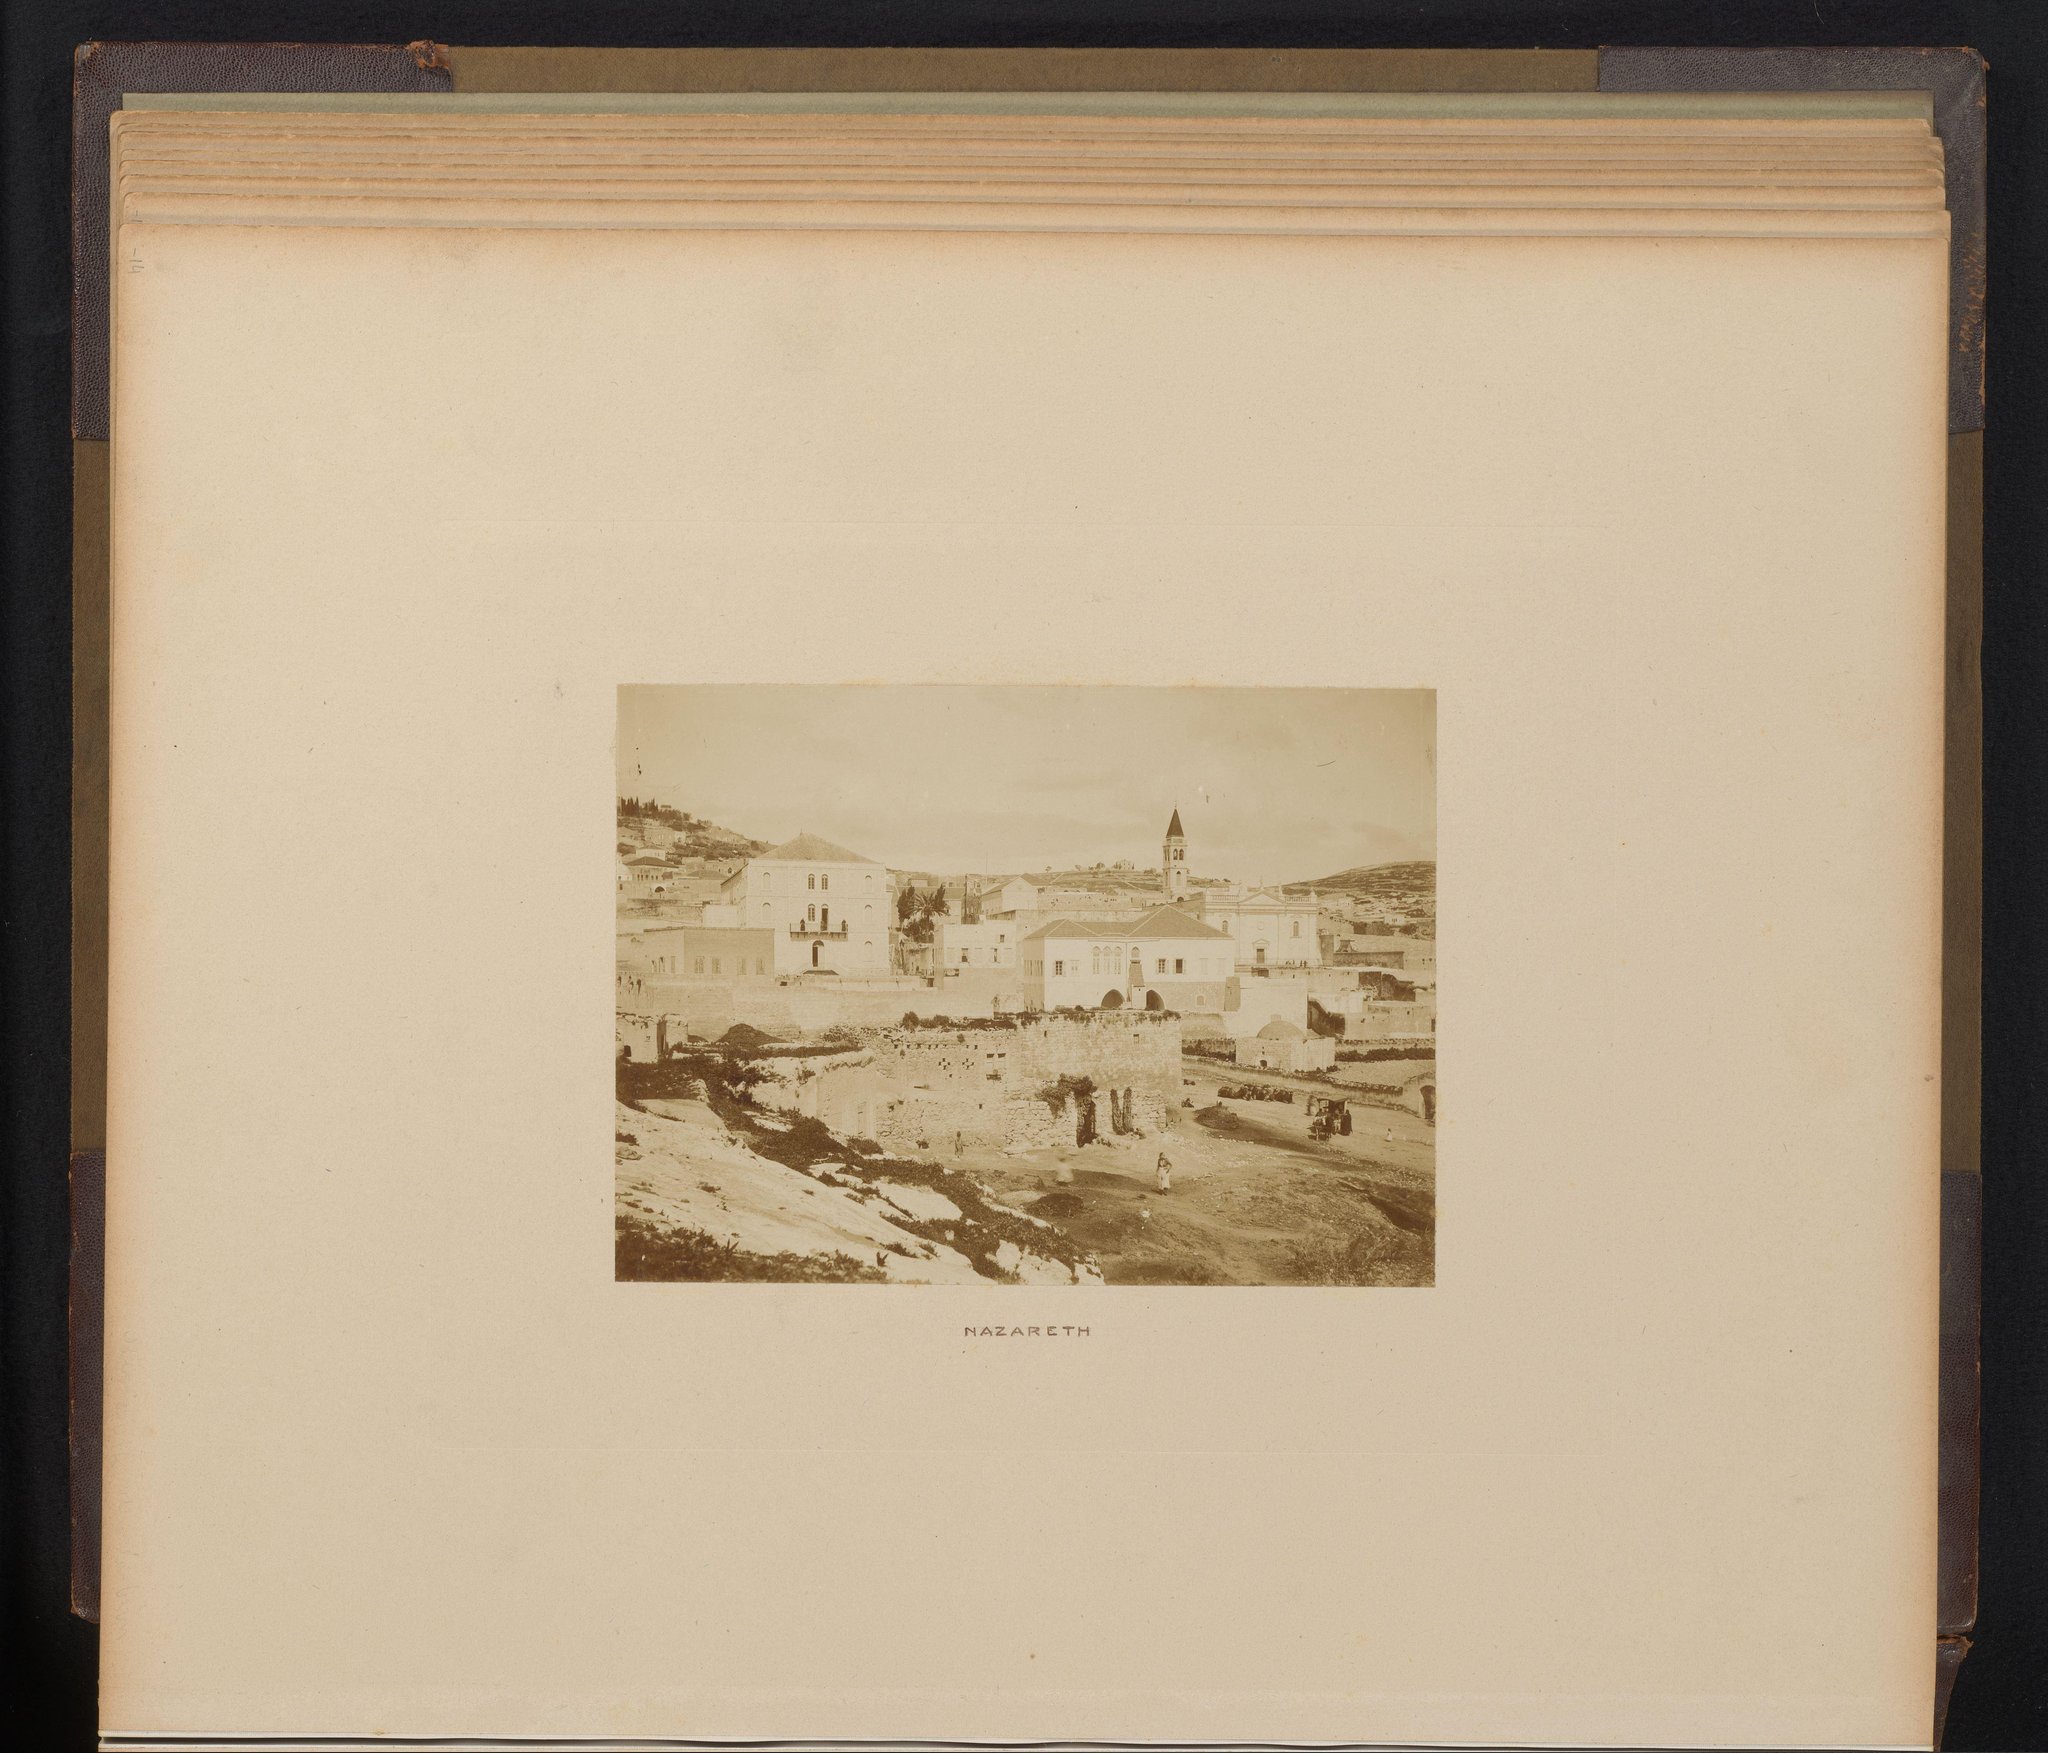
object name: album leaf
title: Gezicht op Nazareth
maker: Anonymous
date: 1880-1910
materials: paper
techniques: collodion silver print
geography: nazareth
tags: city-view in general; 'veduta'